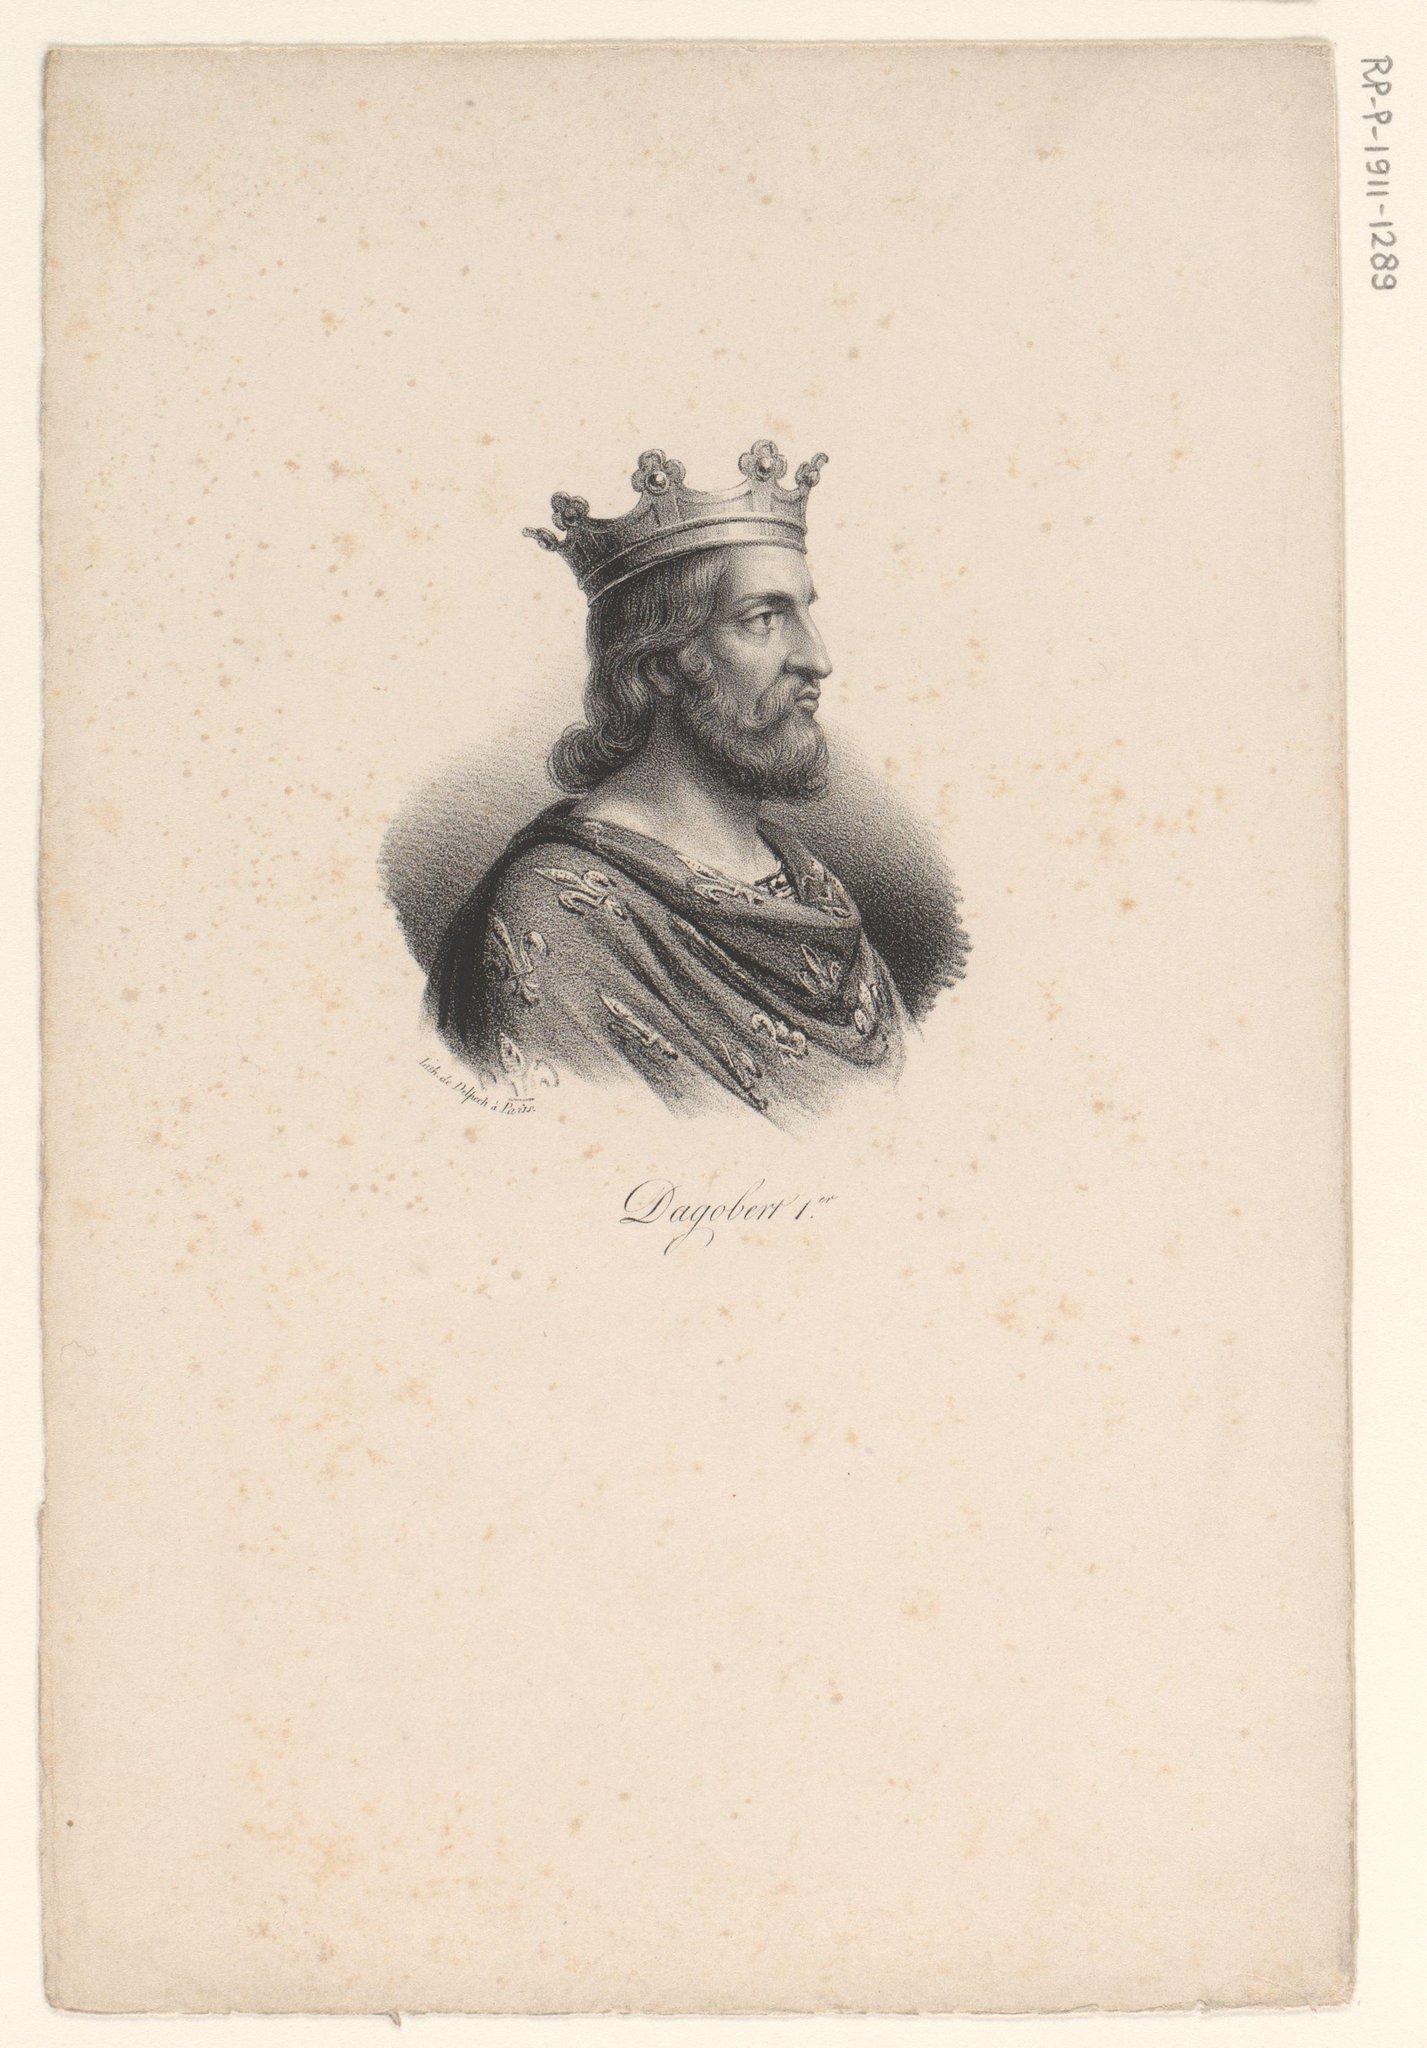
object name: print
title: Dagobert 1er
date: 1818-1842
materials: paper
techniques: lithograph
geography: paris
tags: historical persons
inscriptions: collector's mark: Lugt 2228a